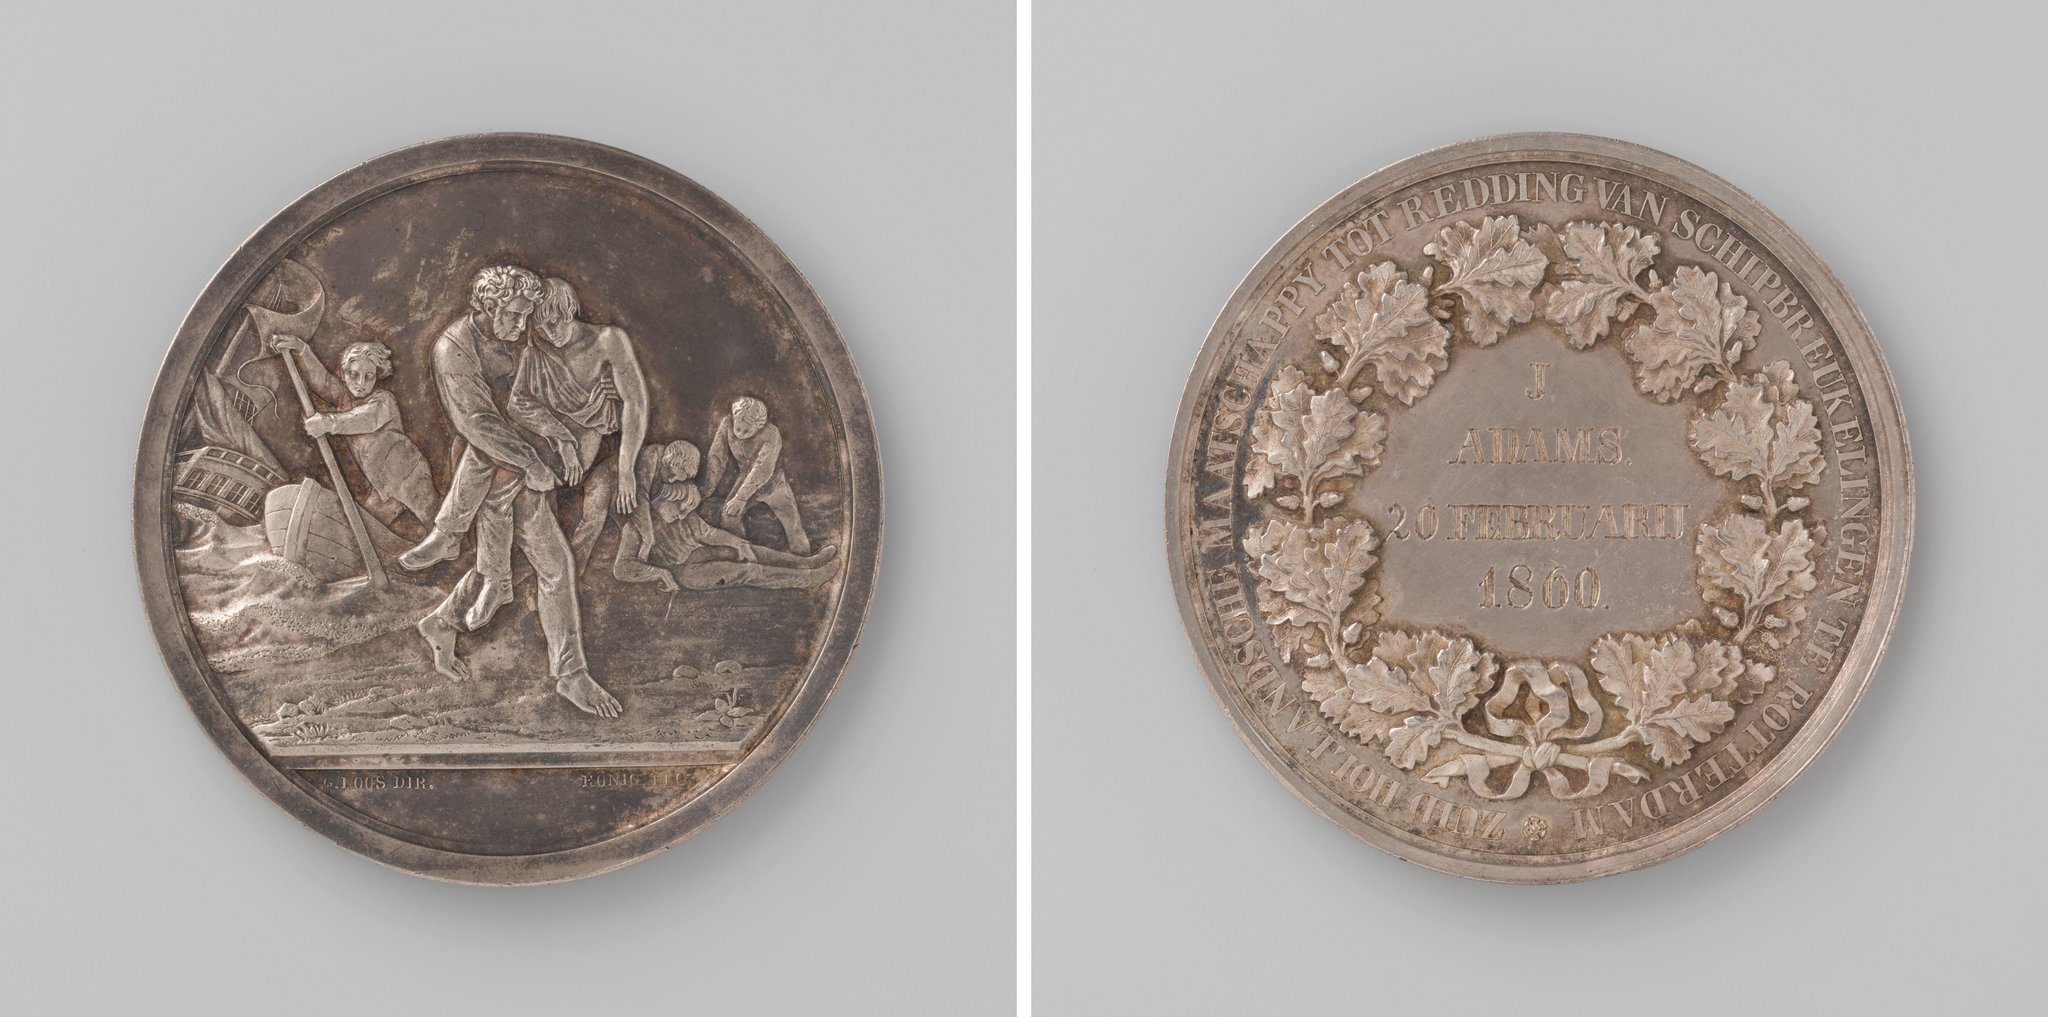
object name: honorary medal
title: Zuid-Hollandsche Maatschappy tot redding van schipbreukelingen te Rotterdam, penning uitgereikt aan J. Adams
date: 1824-1860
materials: silver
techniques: engraving, striking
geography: berlin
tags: rotterdam